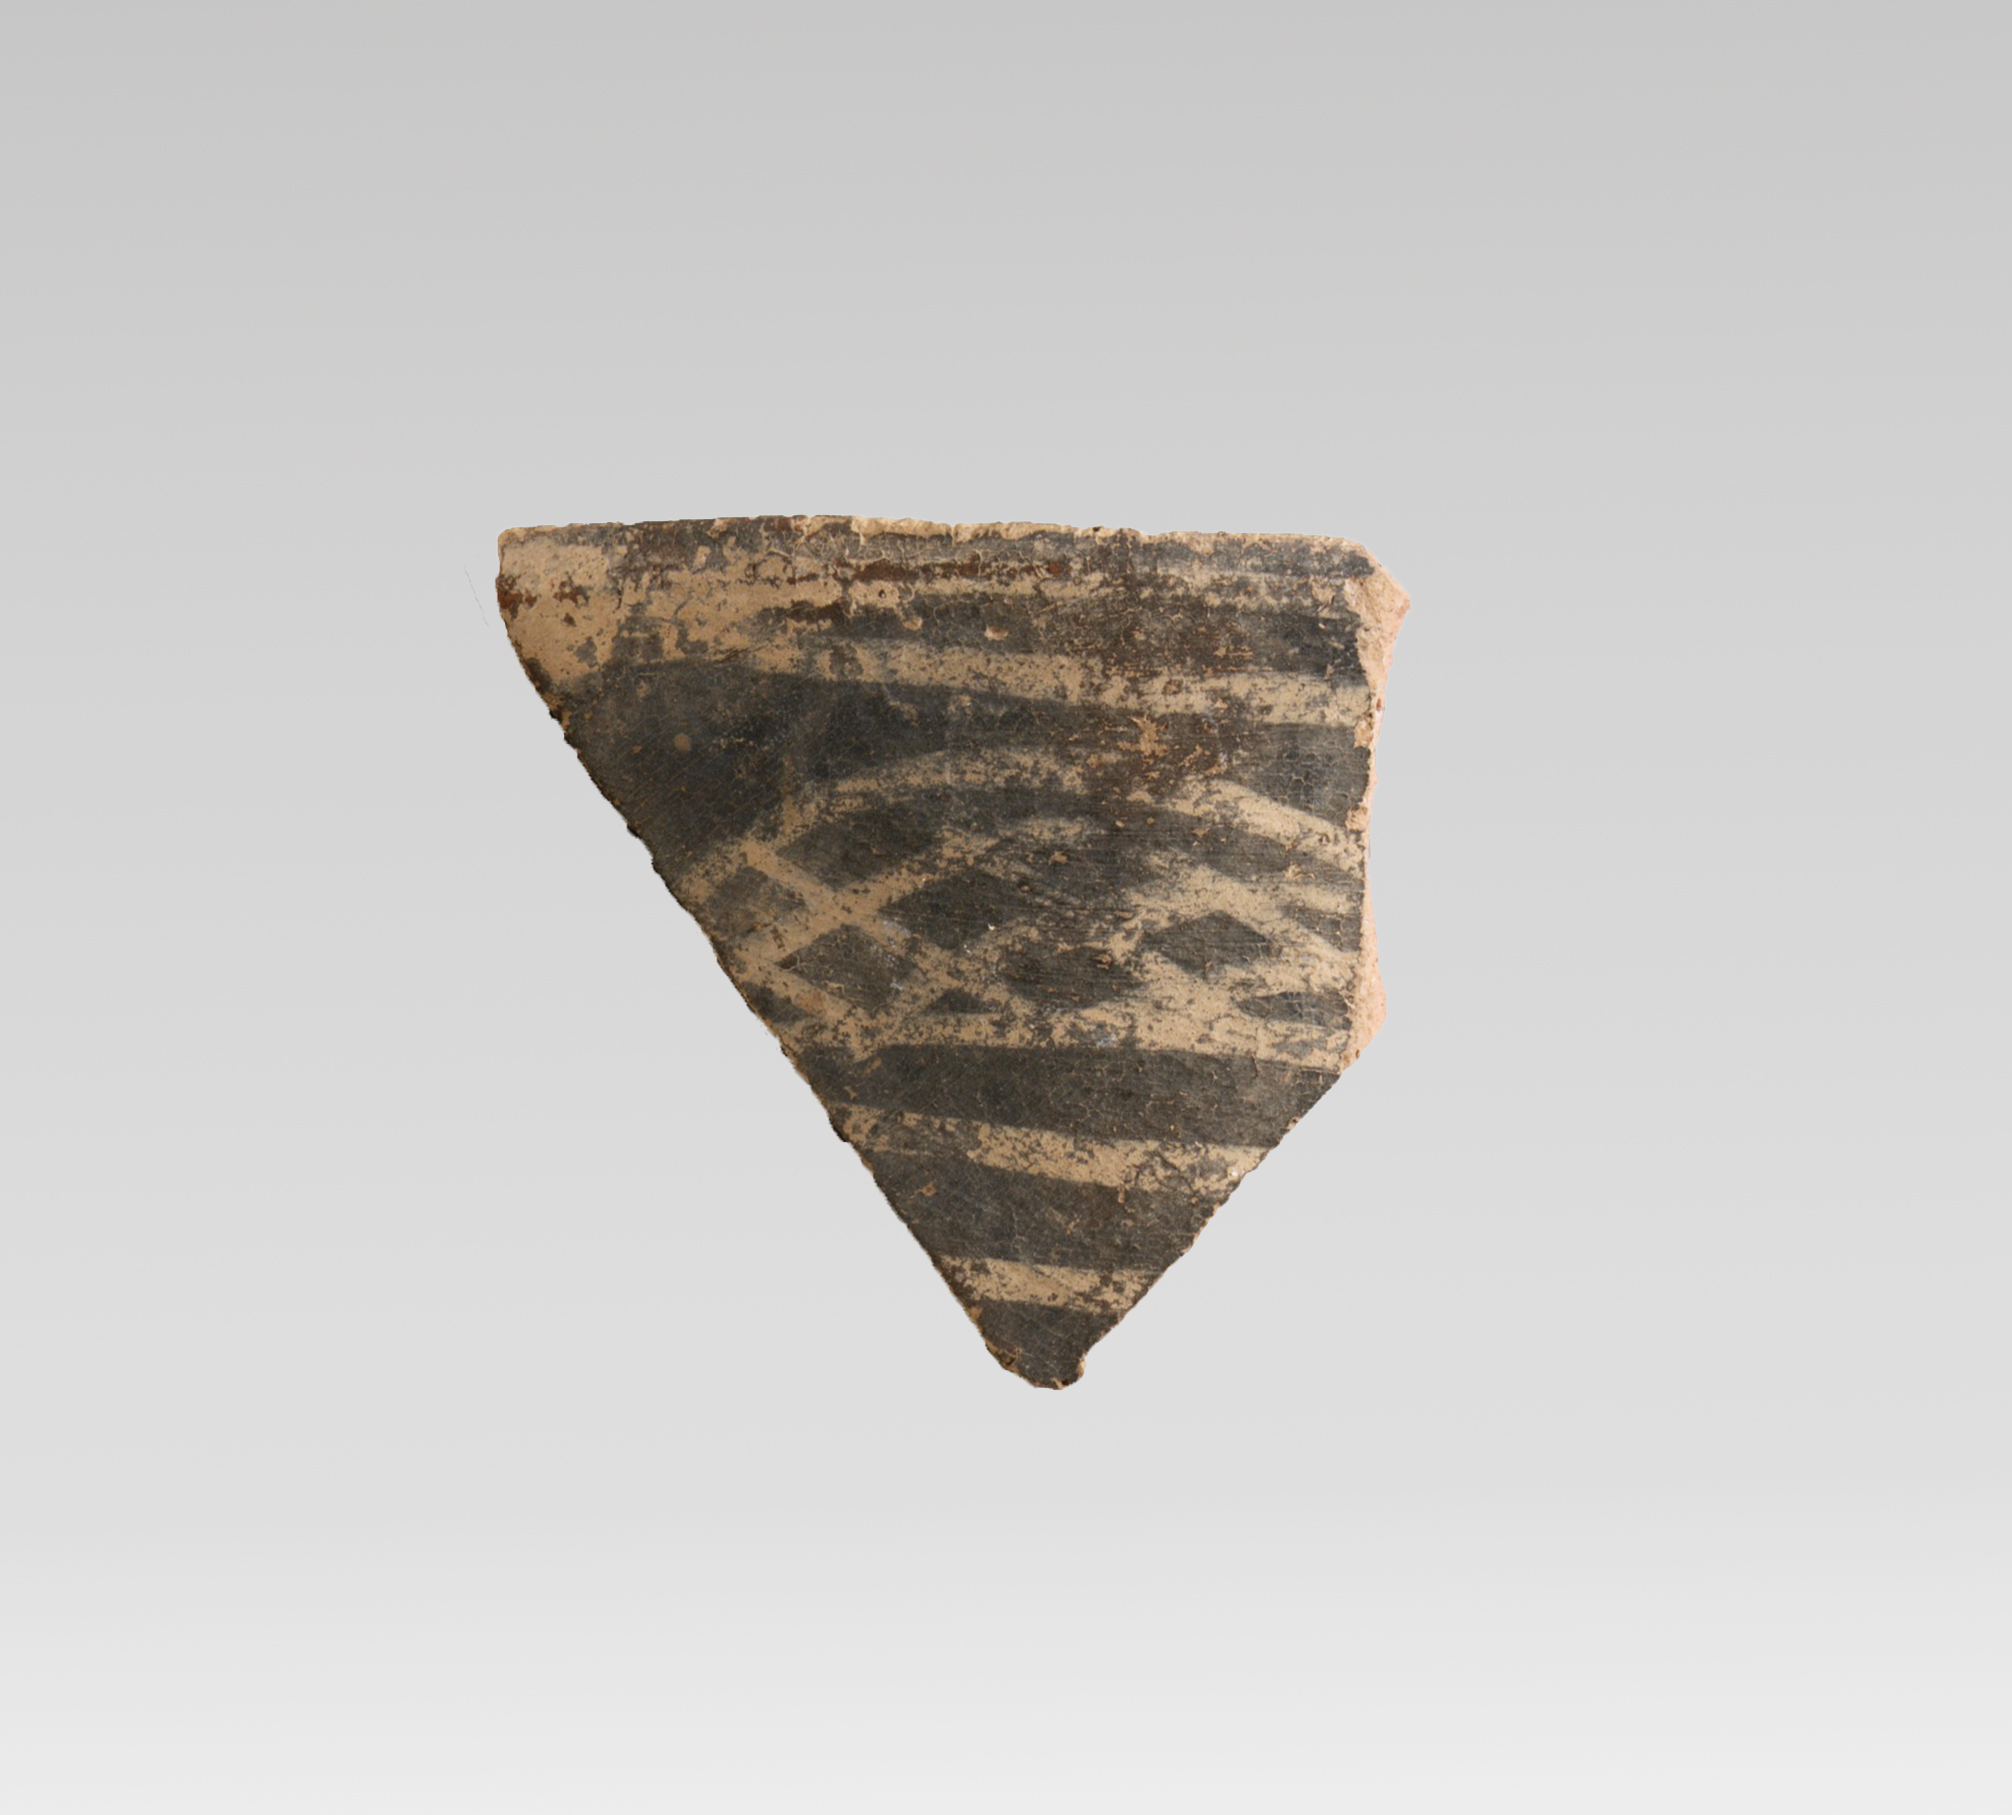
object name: vase fragment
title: Terracotta rim fragment with cross-hatching and bands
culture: minoan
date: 2300-2100 BCE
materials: terracotta